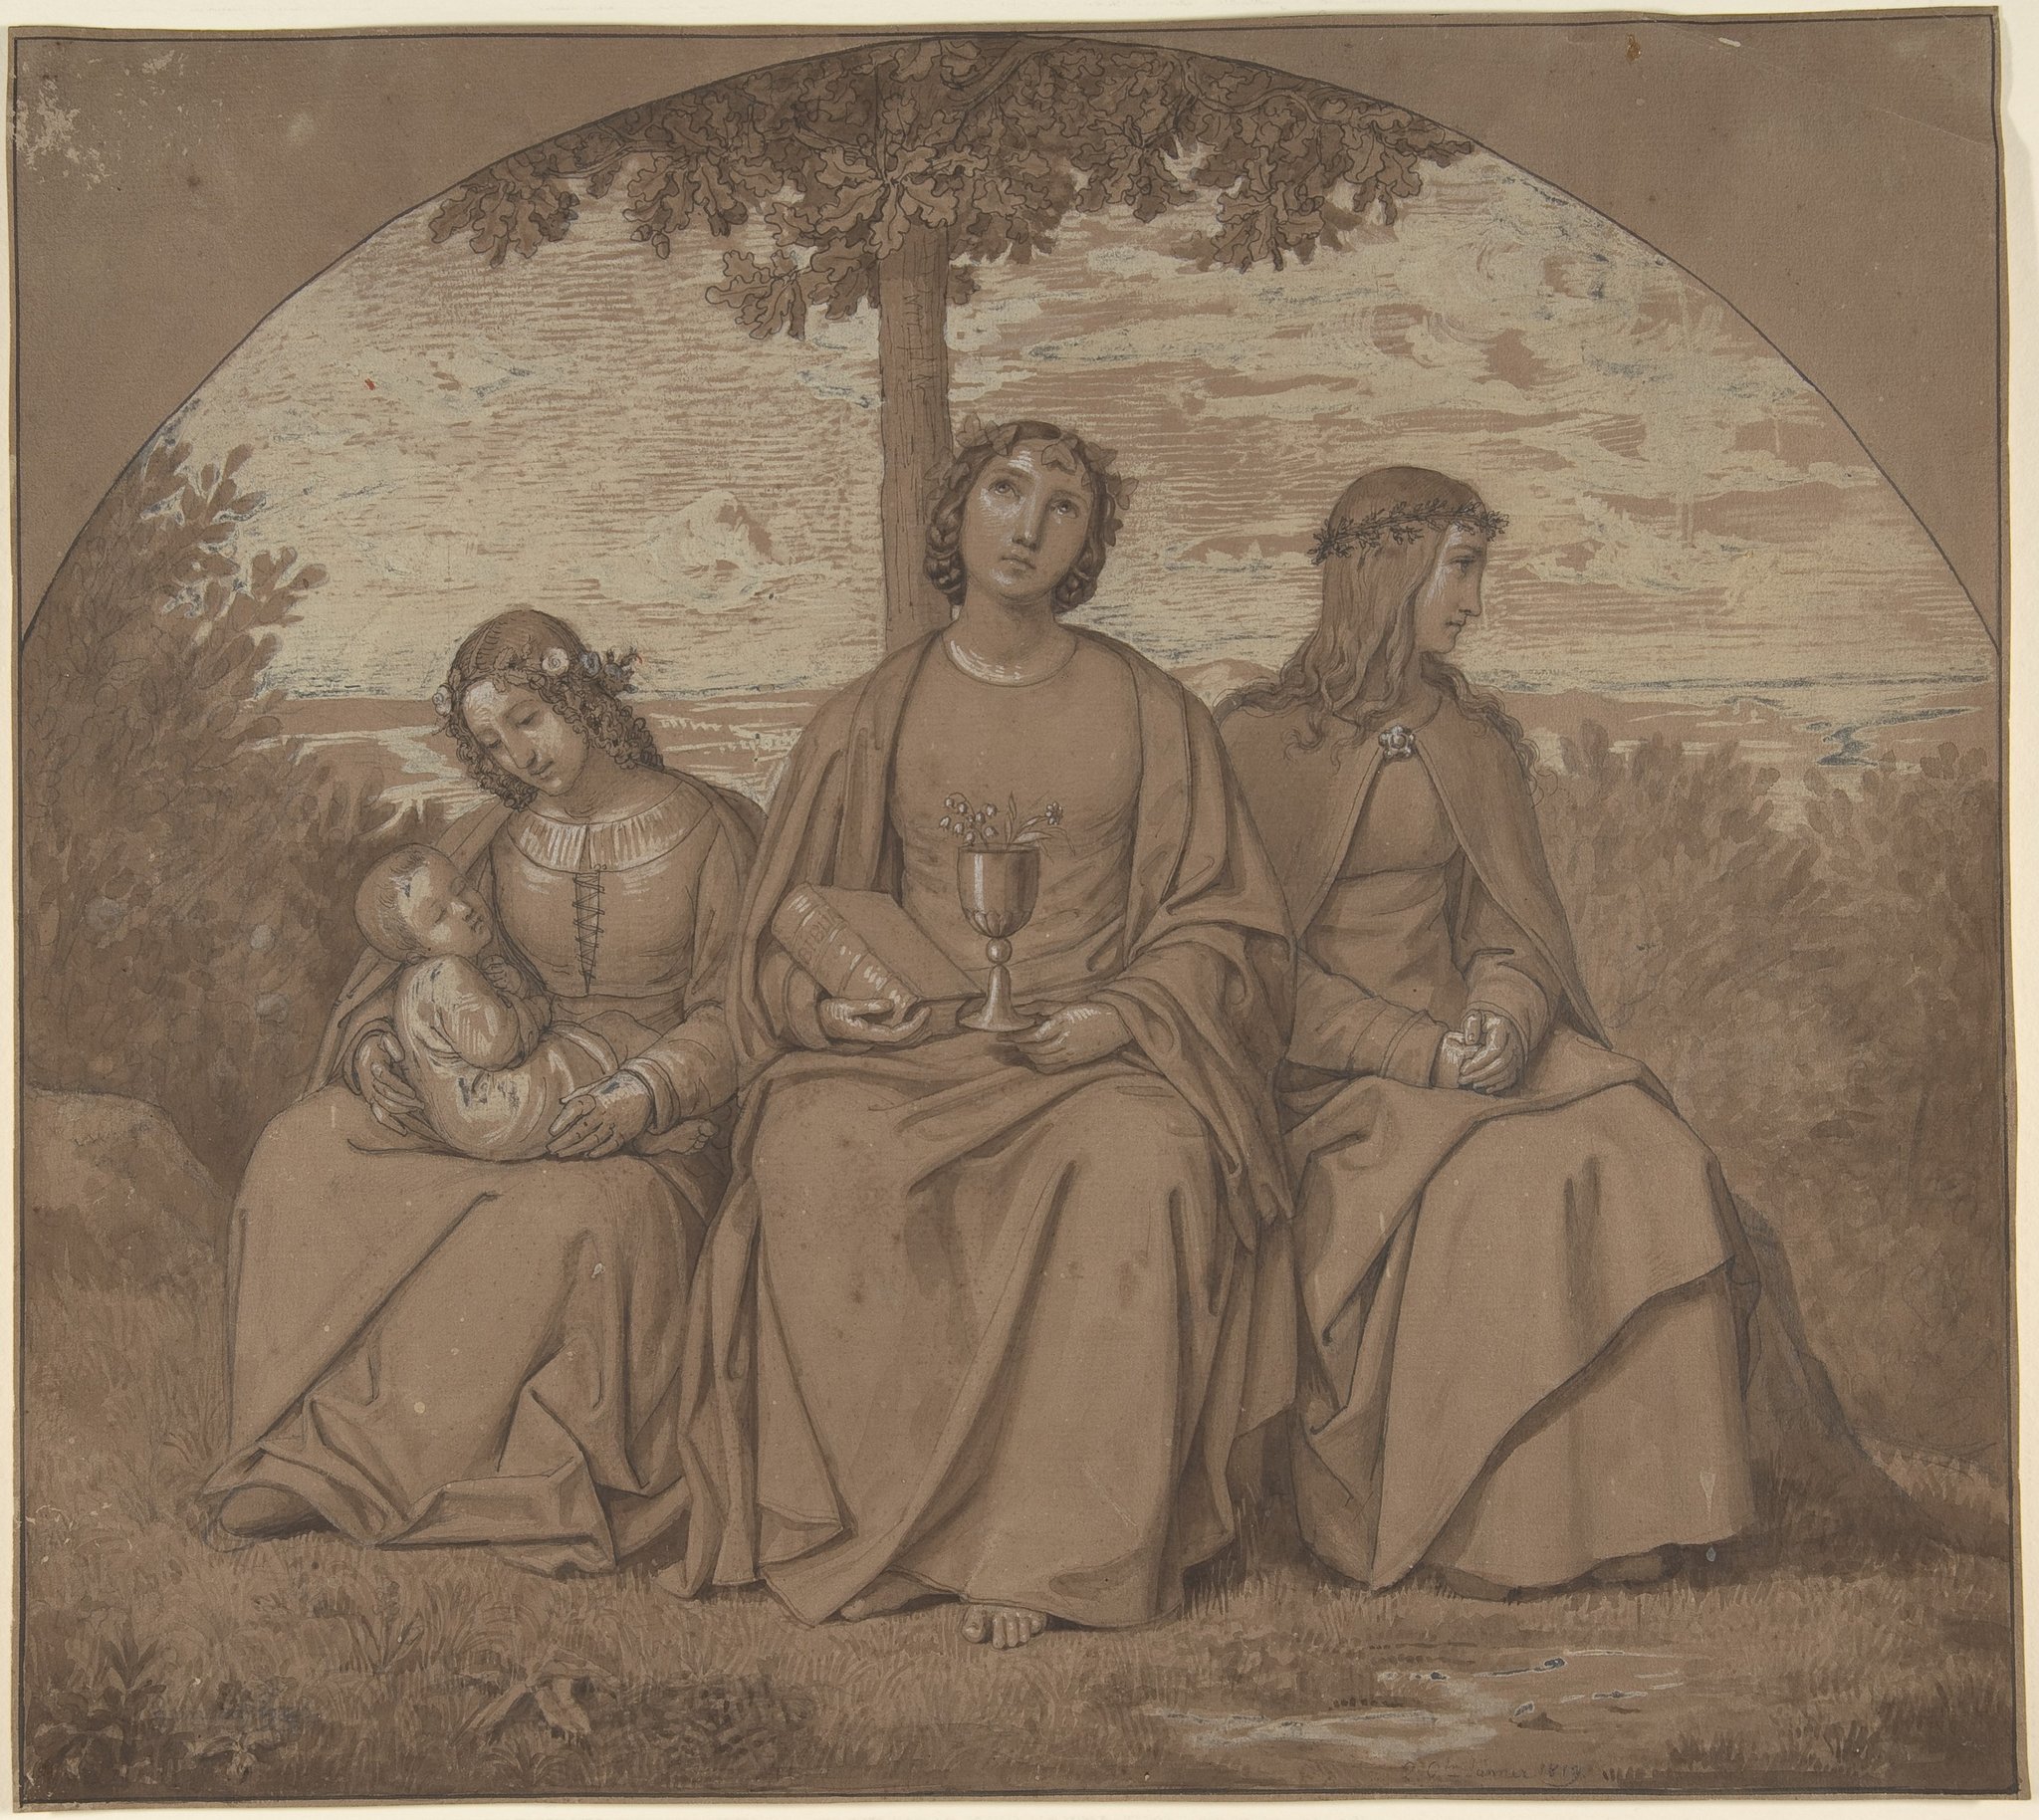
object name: drawing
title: Allegories of Faith, Hope, and Charity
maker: heinrich maria von hess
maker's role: artist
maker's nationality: german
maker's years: 1798-1863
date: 1819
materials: graphite, ink, paper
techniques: brush, heightening, pen, wash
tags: children,women